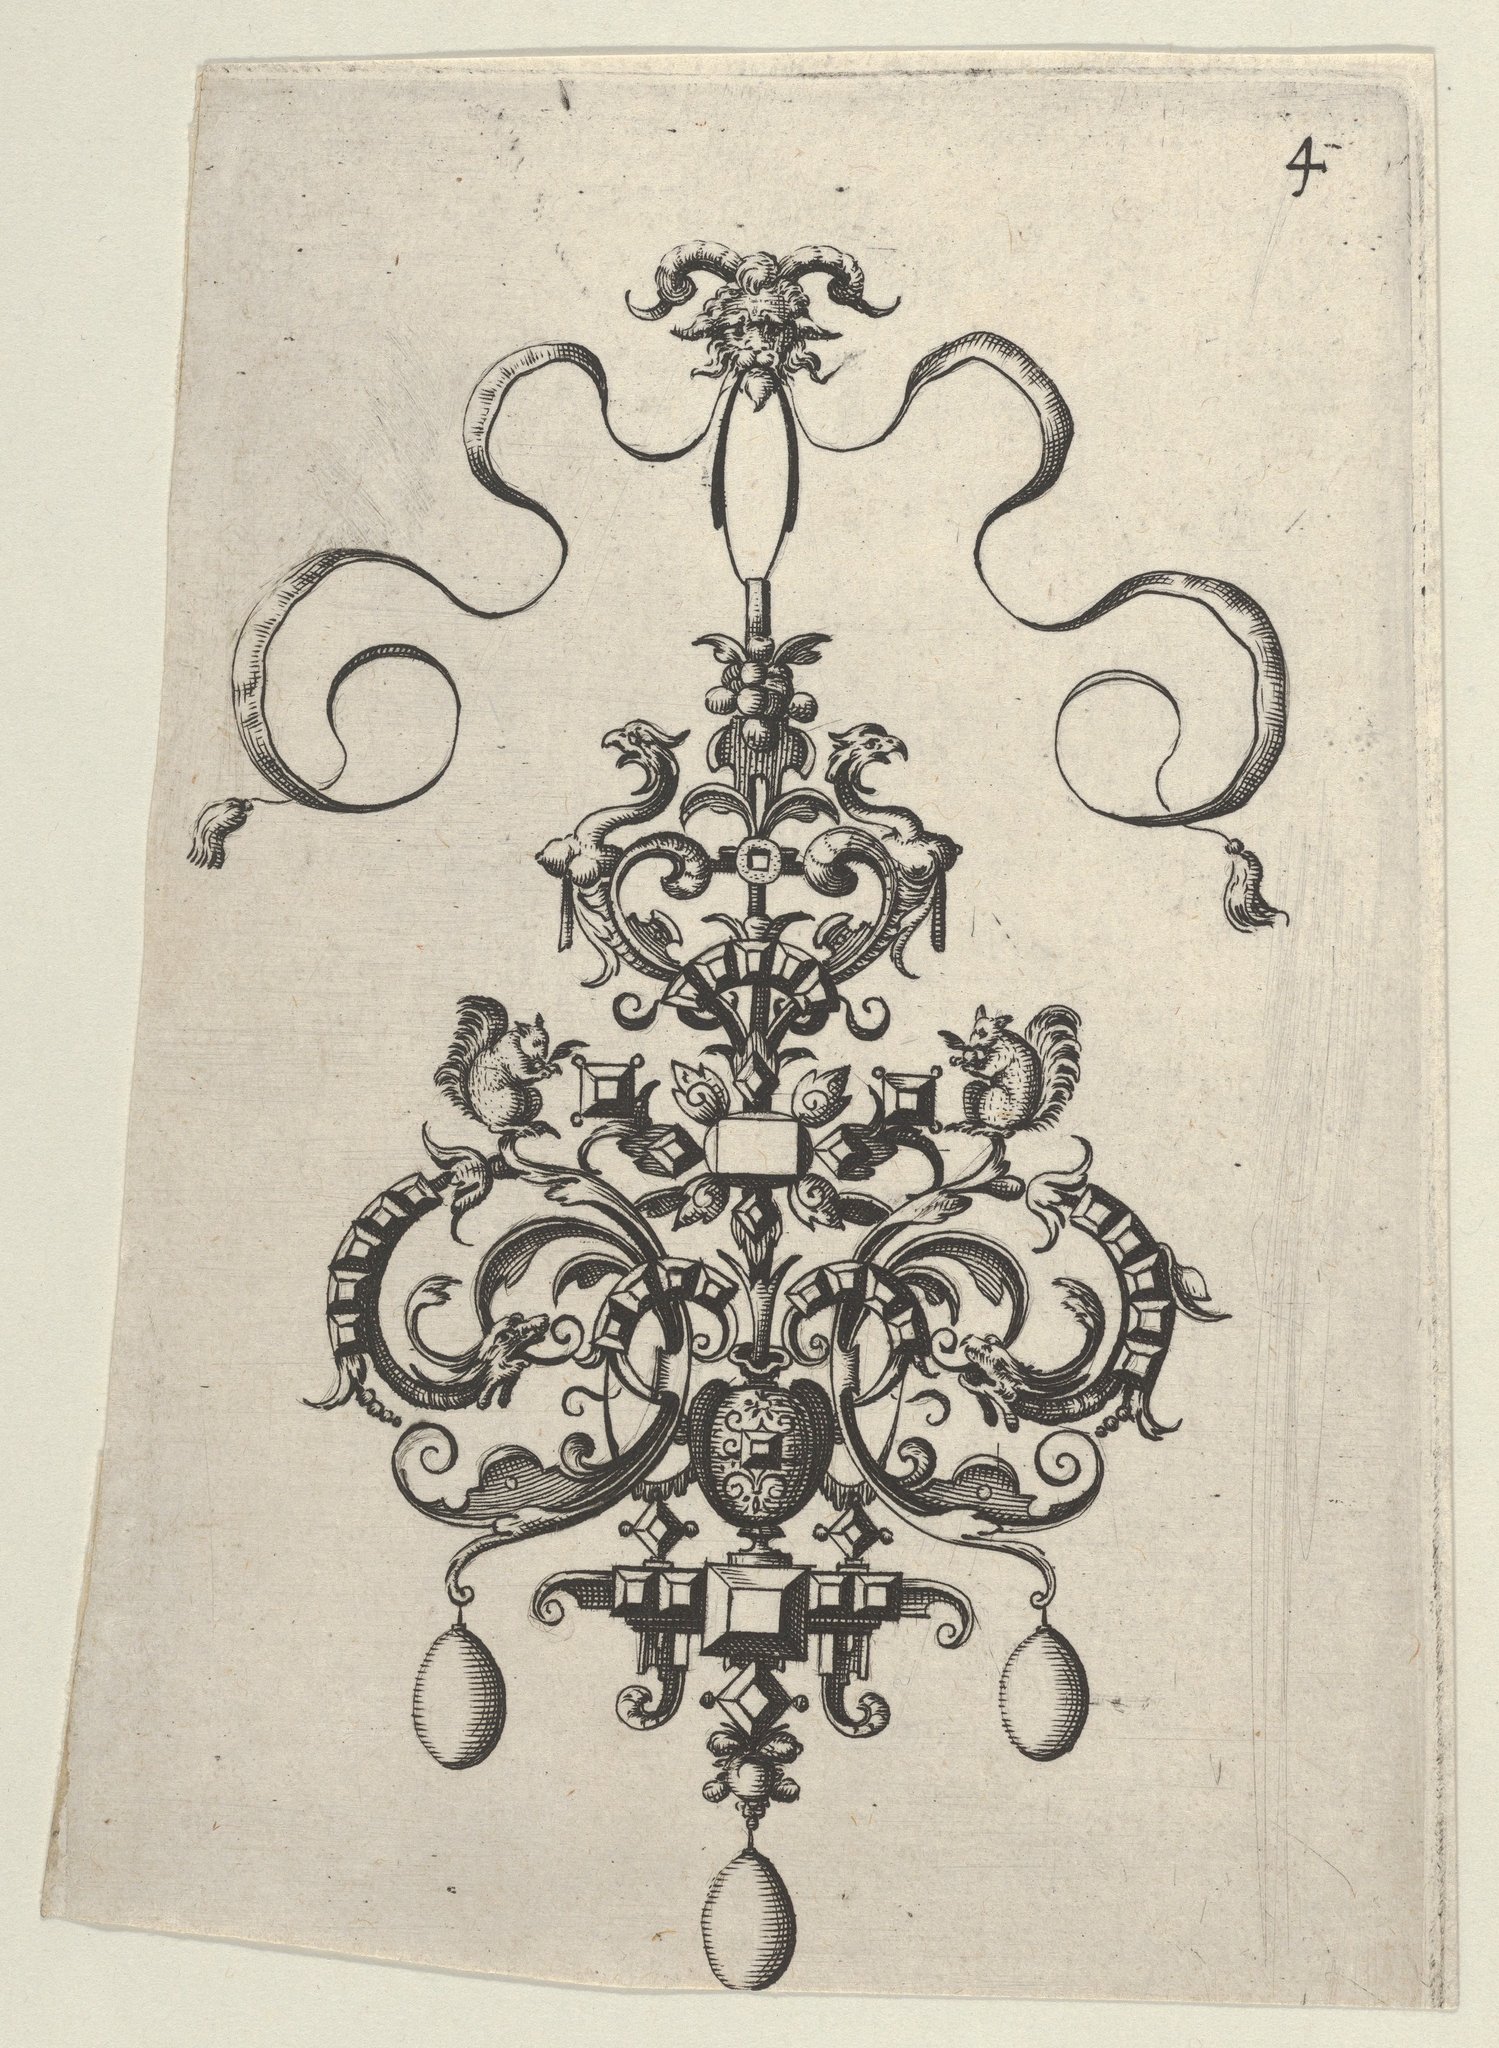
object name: print ornament architecture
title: Reverse Copy of Design for a Pendant, from Ars His Myronis Nobilis Effingitus Pagellulis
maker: paul birckenhultz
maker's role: artist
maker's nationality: german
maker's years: 1561-1639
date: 1600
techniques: engraving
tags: pendants,squirrels